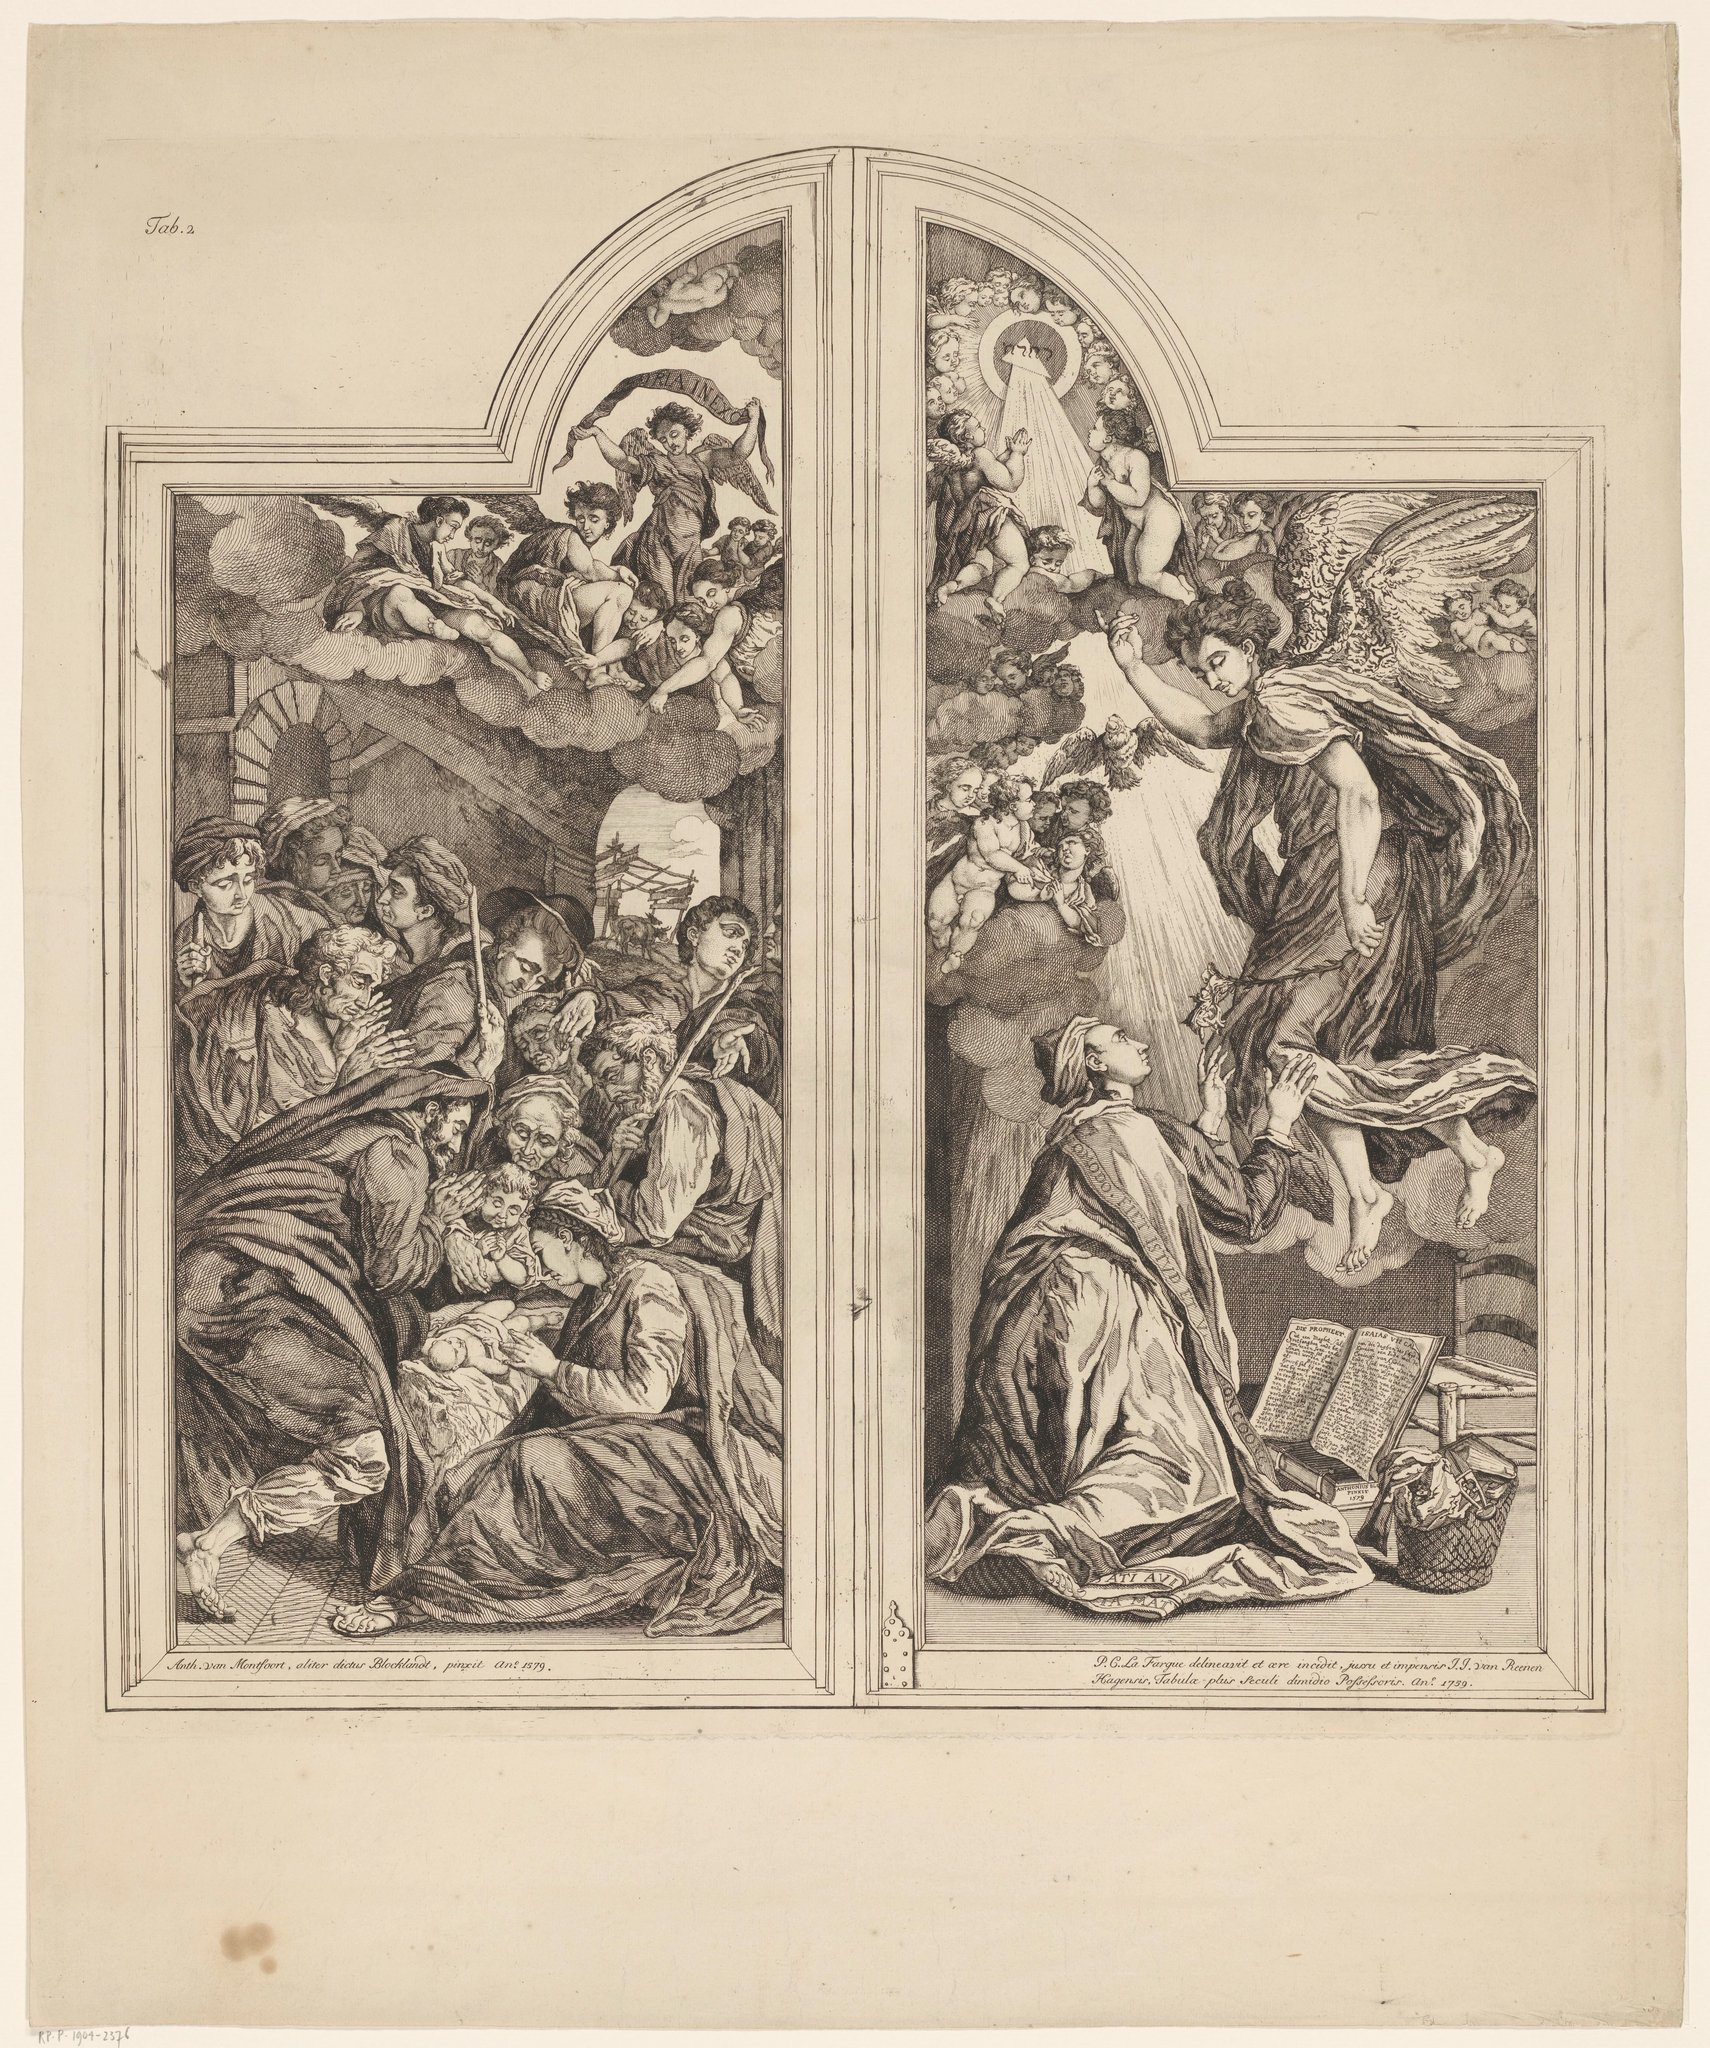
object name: print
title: Annunciatie en de aanbidding door de herders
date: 1759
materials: paper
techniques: engraving, etching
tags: adoration of the christ-child by the shepherds; mary and joseph present, the annunciation: mary kneeling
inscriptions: collector's mark: Lugt 2228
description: Onderdeel van een prent naar het drieluik naar Anthony van Blocklandt. Het middenpaneel vertoont de Hemelvaart van Maria, het linkerpaneel de Aanbidding door de herders en het rechterpaneel de Annunciatie. De achterzijden van de zijpanelen vertonen links Maria met kind en rechts de opdrachtgever met de apostel Andreas en de aartsengel Michael.